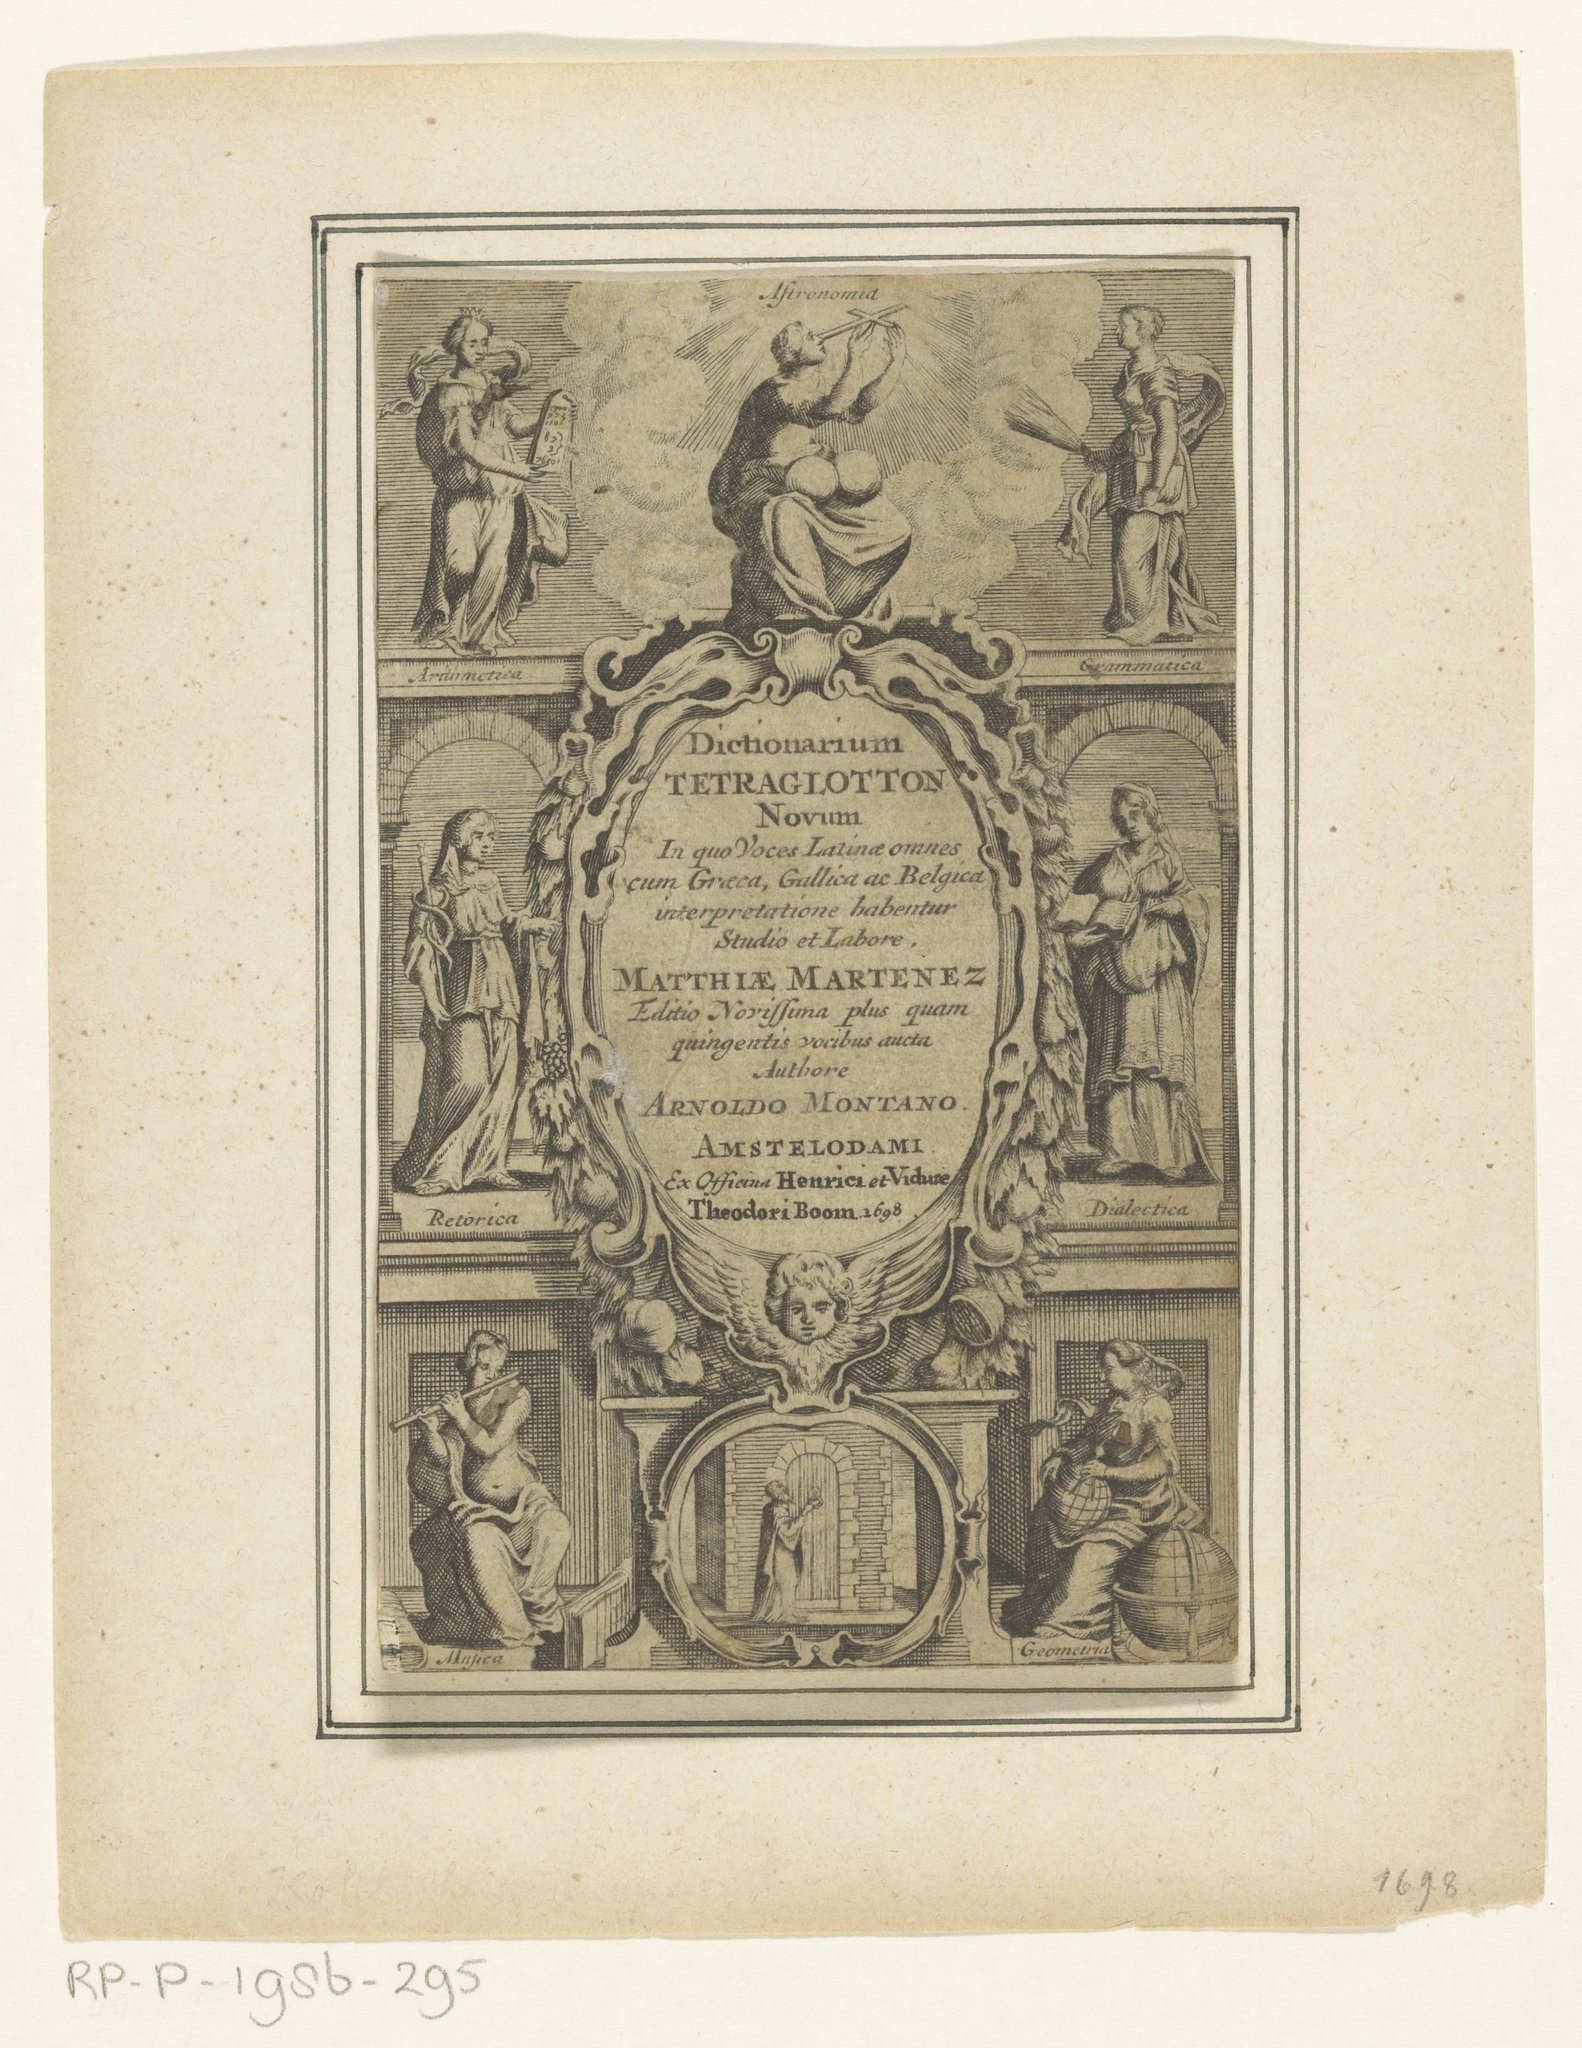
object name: print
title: Titelpagina voor: Arnoldus Montanus, Dictionarium Tetraglotton Novum, 1698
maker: Anonymous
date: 1698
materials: paper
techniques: engraving, etching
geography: amsterdam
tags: the liberal arts, 'artes liberales'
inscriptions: collector's mark: Lugt 2228, collector's mark: Lugt 2760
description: Vrouwelijke personificaties van de zeven vrije kunsten, Arithmetica, Astronomia, Grammatica, Retorica, Dialectica, Musica en Geometria met bijbehorende attributen rondom een cartouche met titel van het boek.